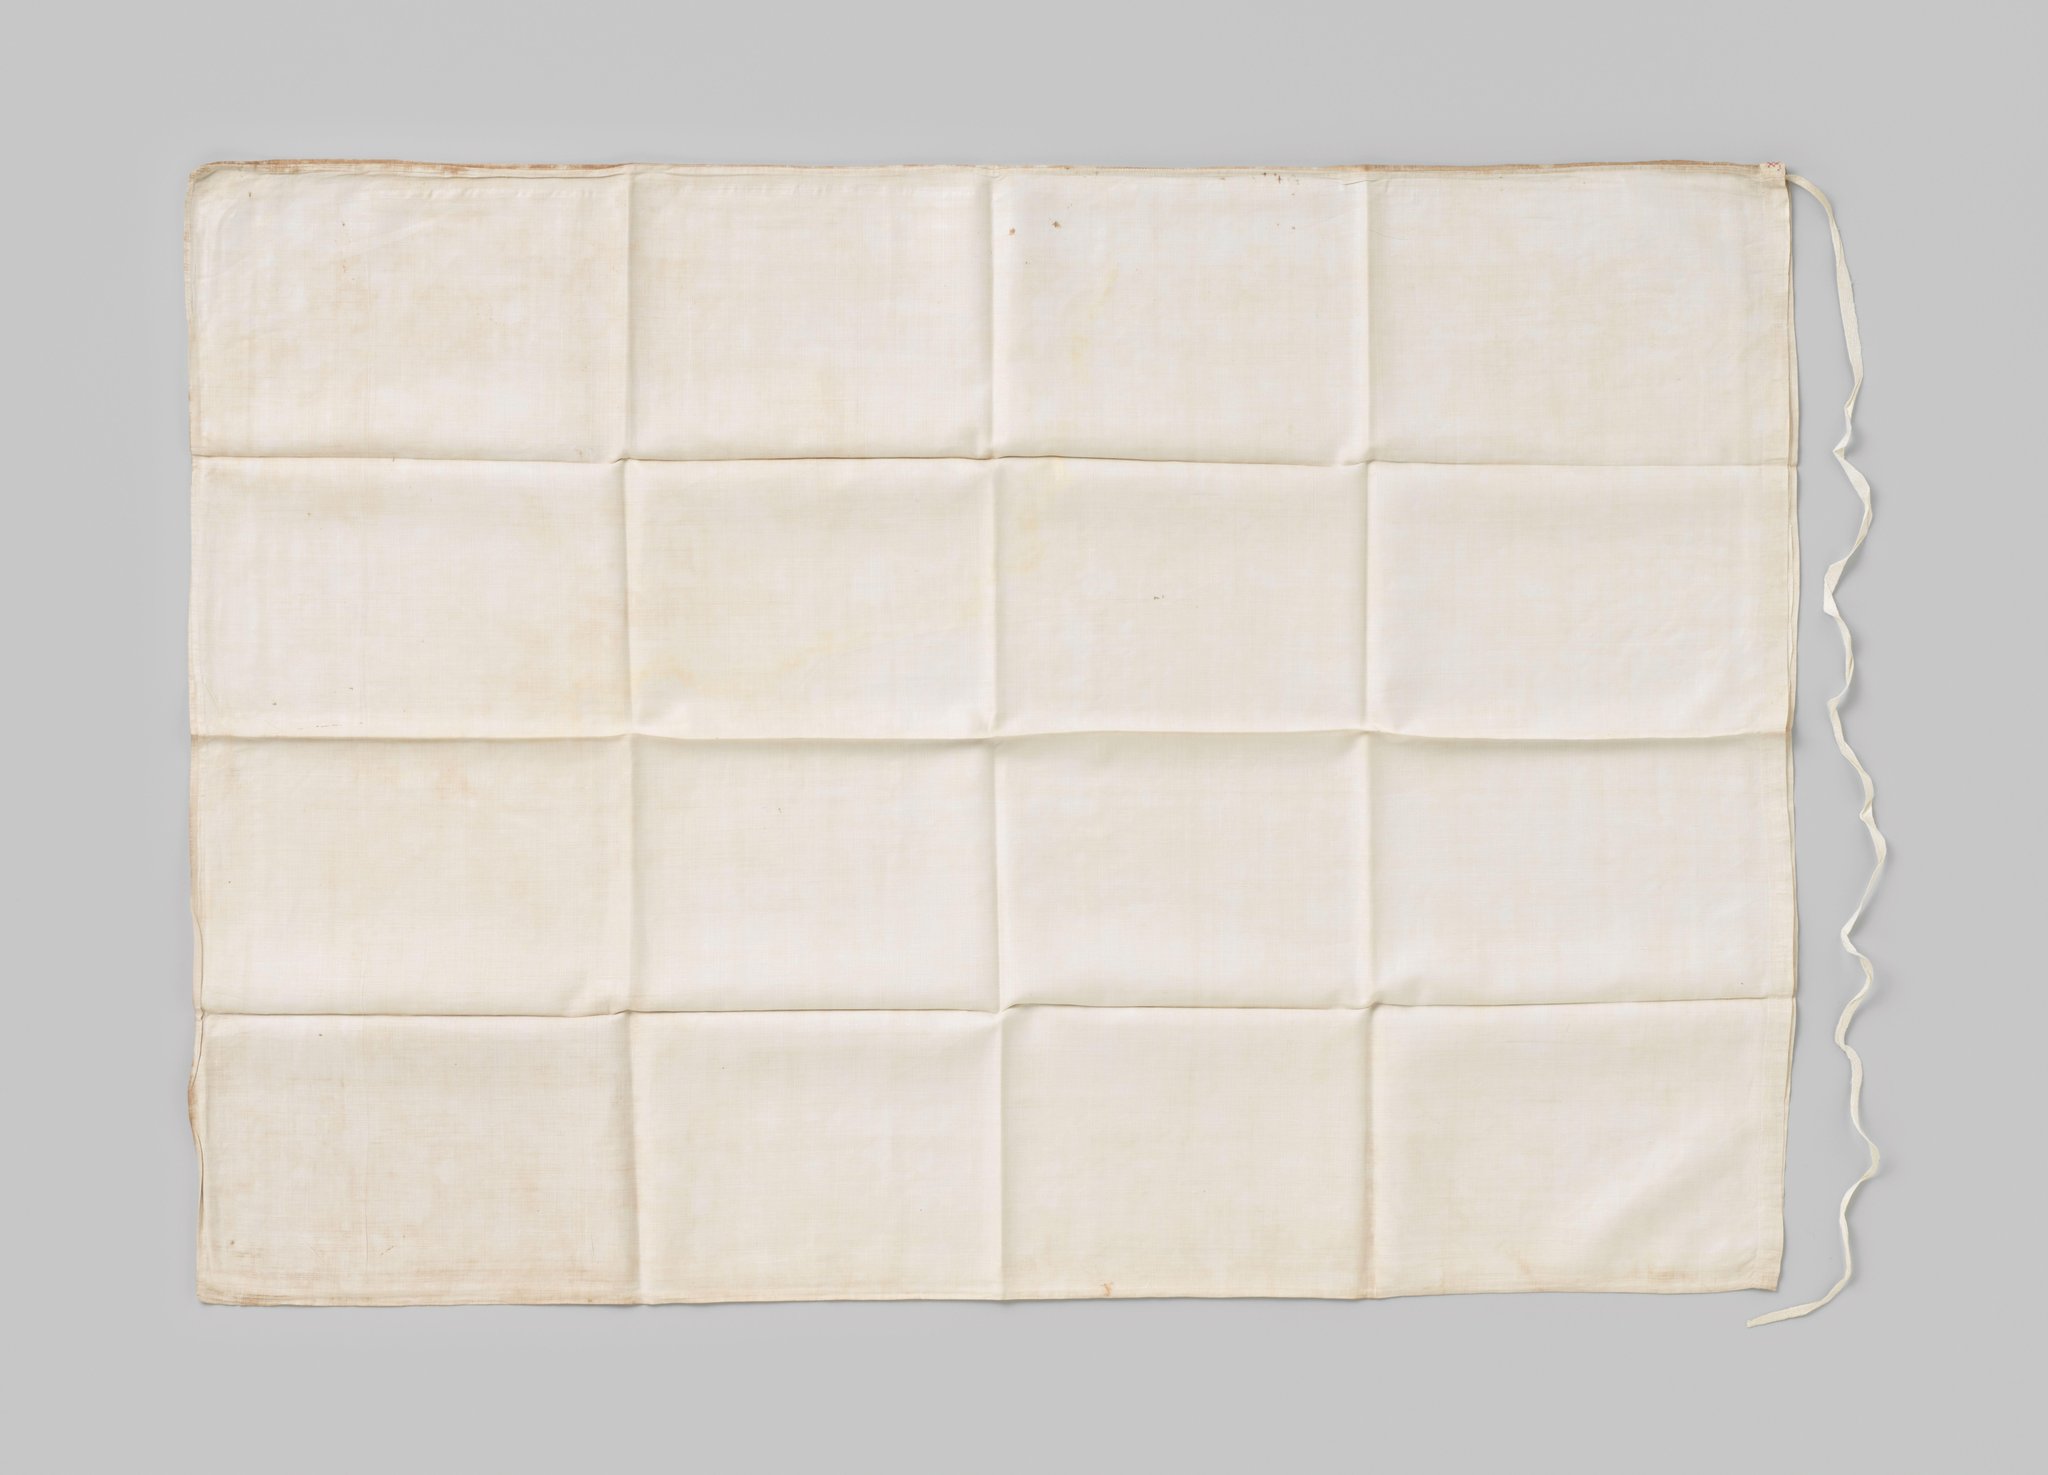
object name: sloop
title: Sloop van wit linnen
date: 1670-1770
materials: linen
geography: northern netherlands